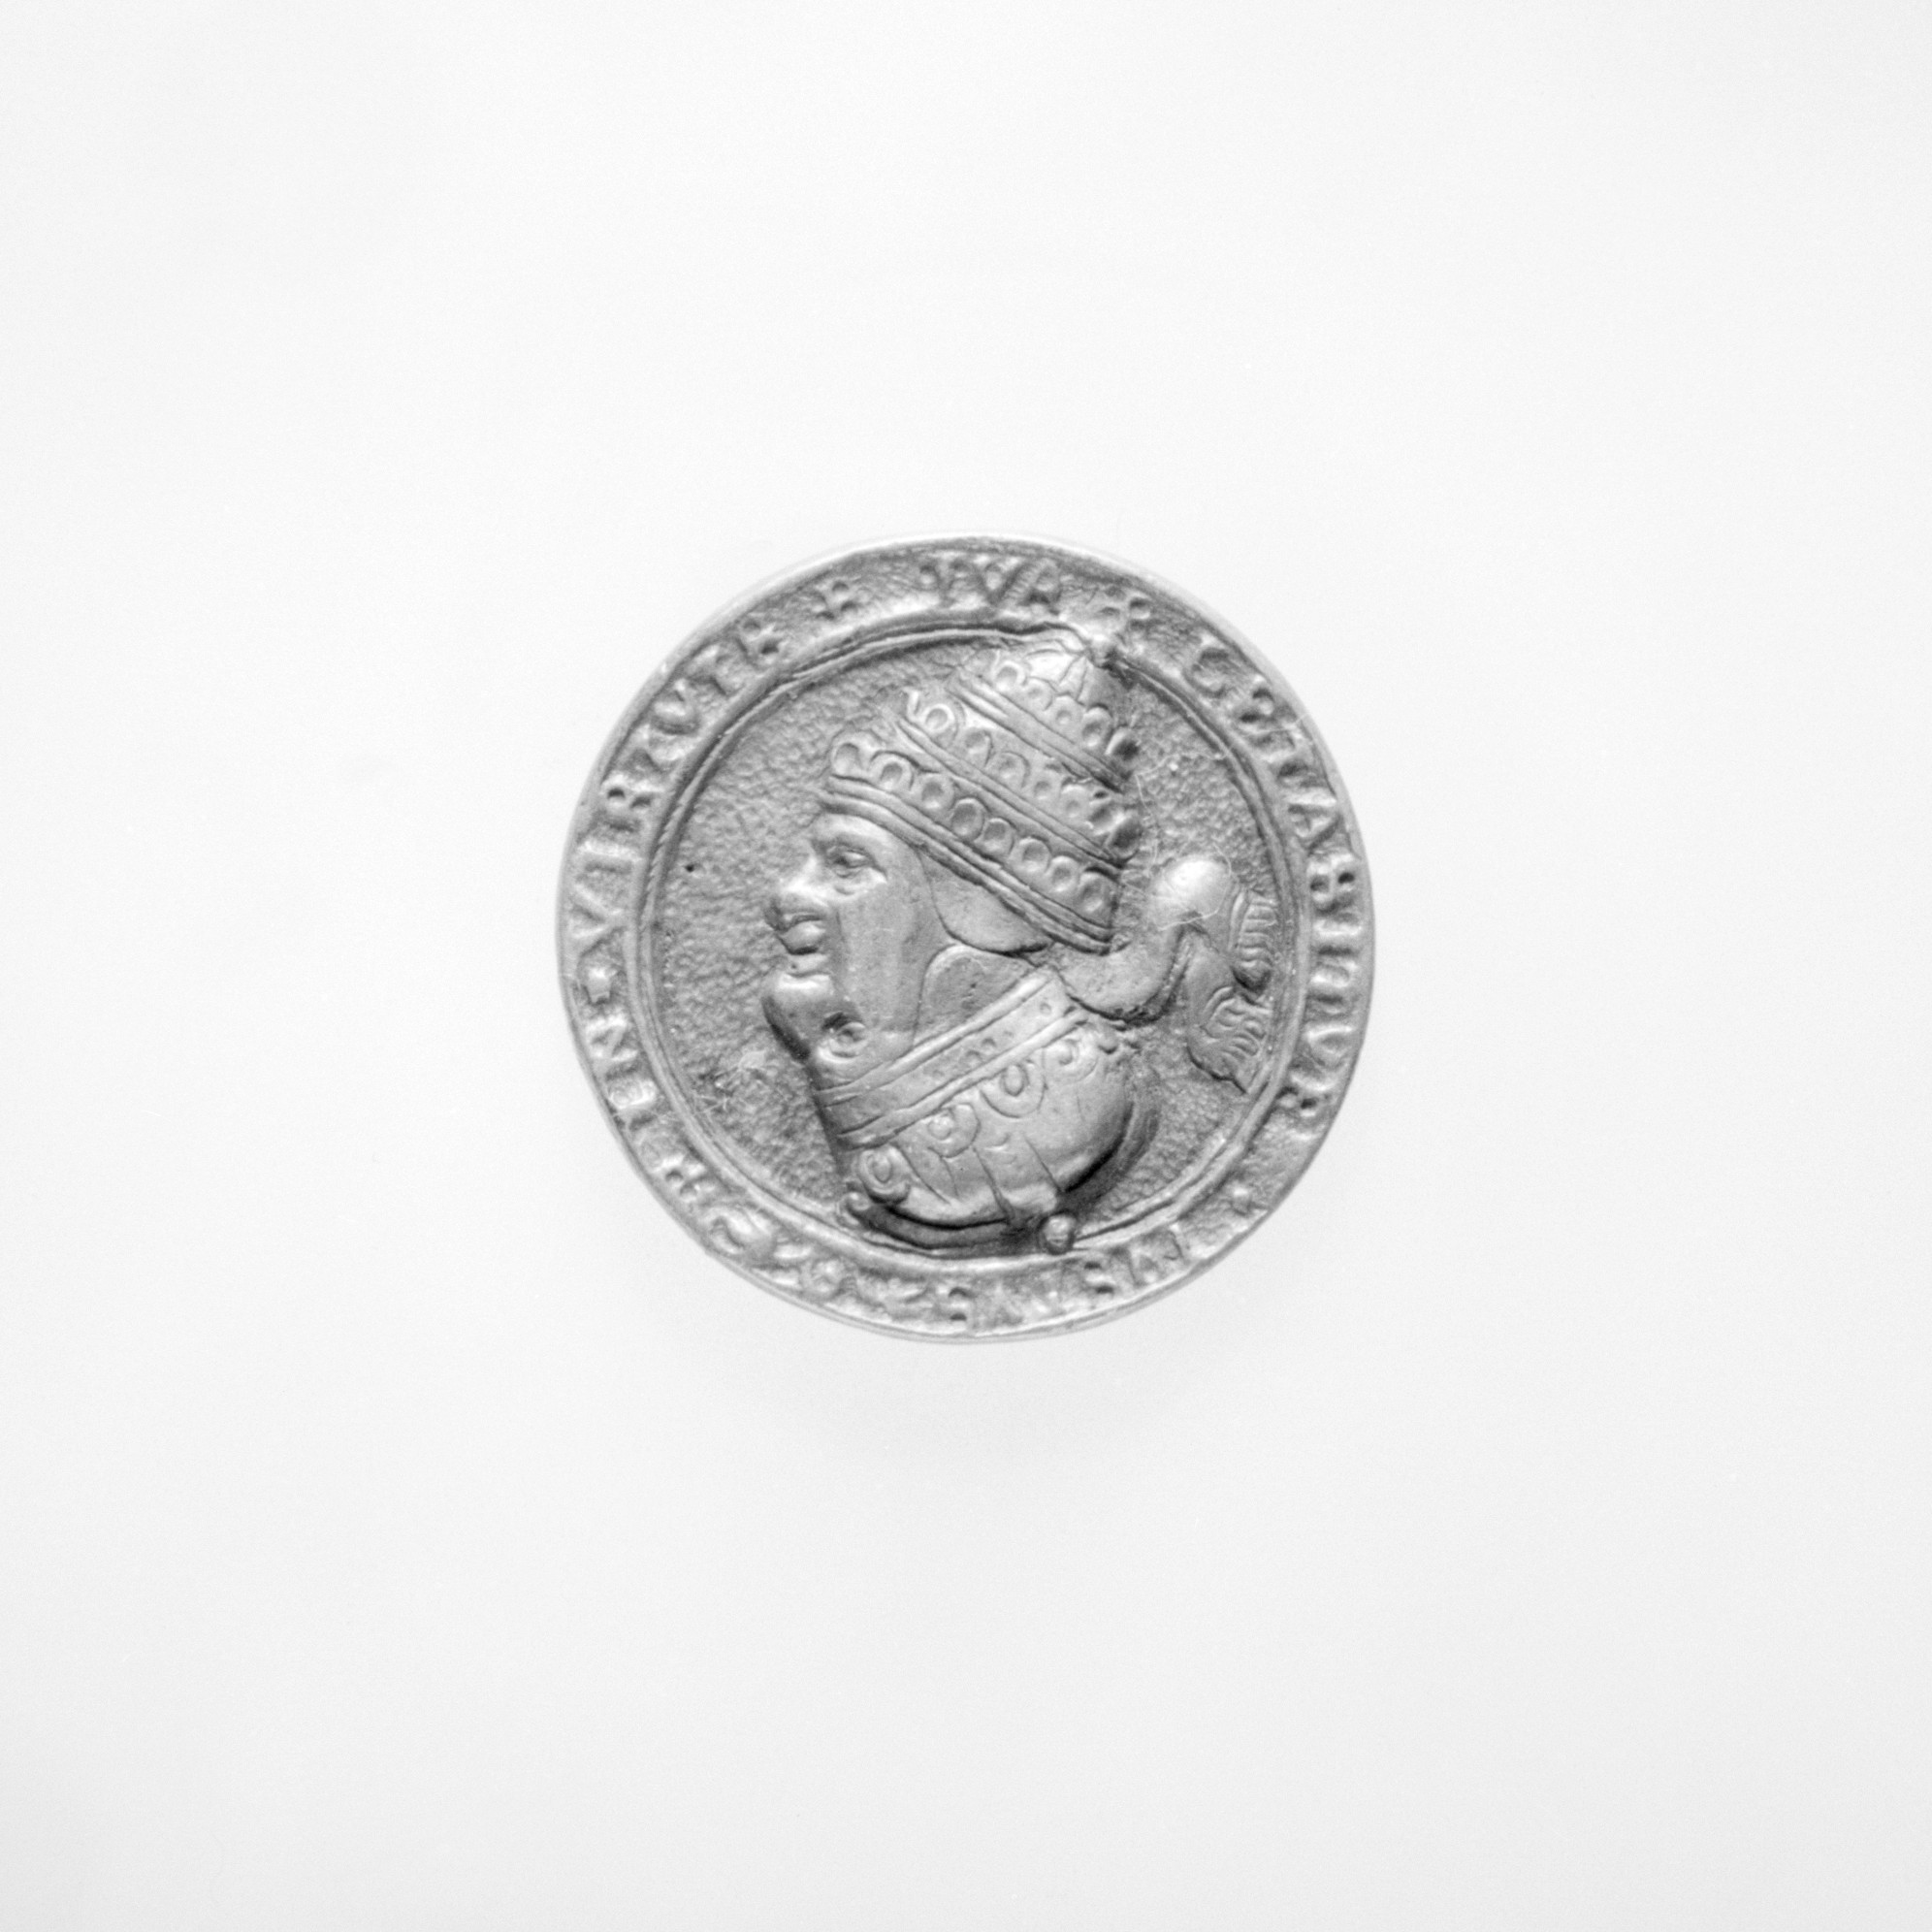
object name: medal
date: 1501-1600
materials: silver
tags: men,profiles